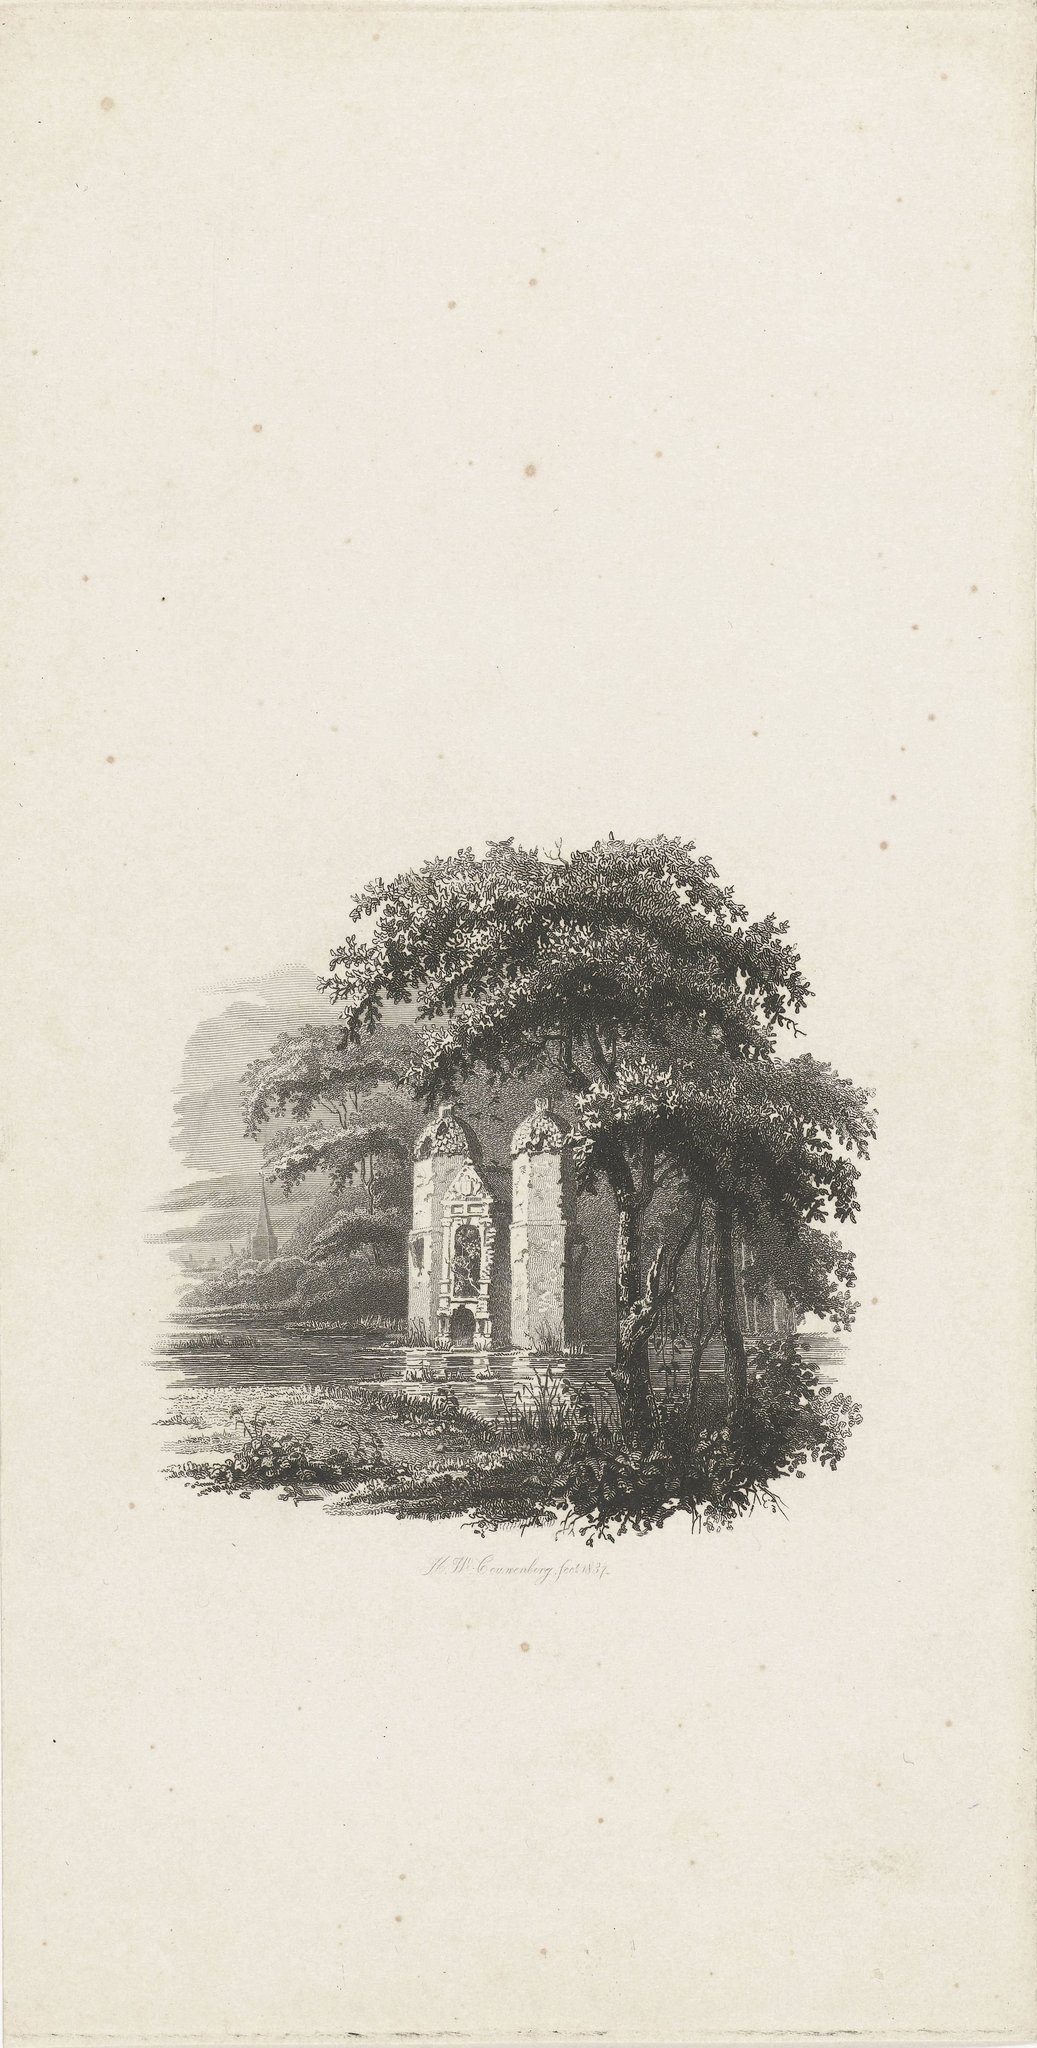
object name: book illustration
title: Landschap met vervallen monument in een waterplas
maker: henricus wilhelmus couwenberg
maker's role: draughtsman, print maker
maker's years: 1814-1845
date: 1837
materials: paper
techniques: etching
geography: amsterdam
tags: landscape with monument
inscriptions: collector's mark: Lugt 2228